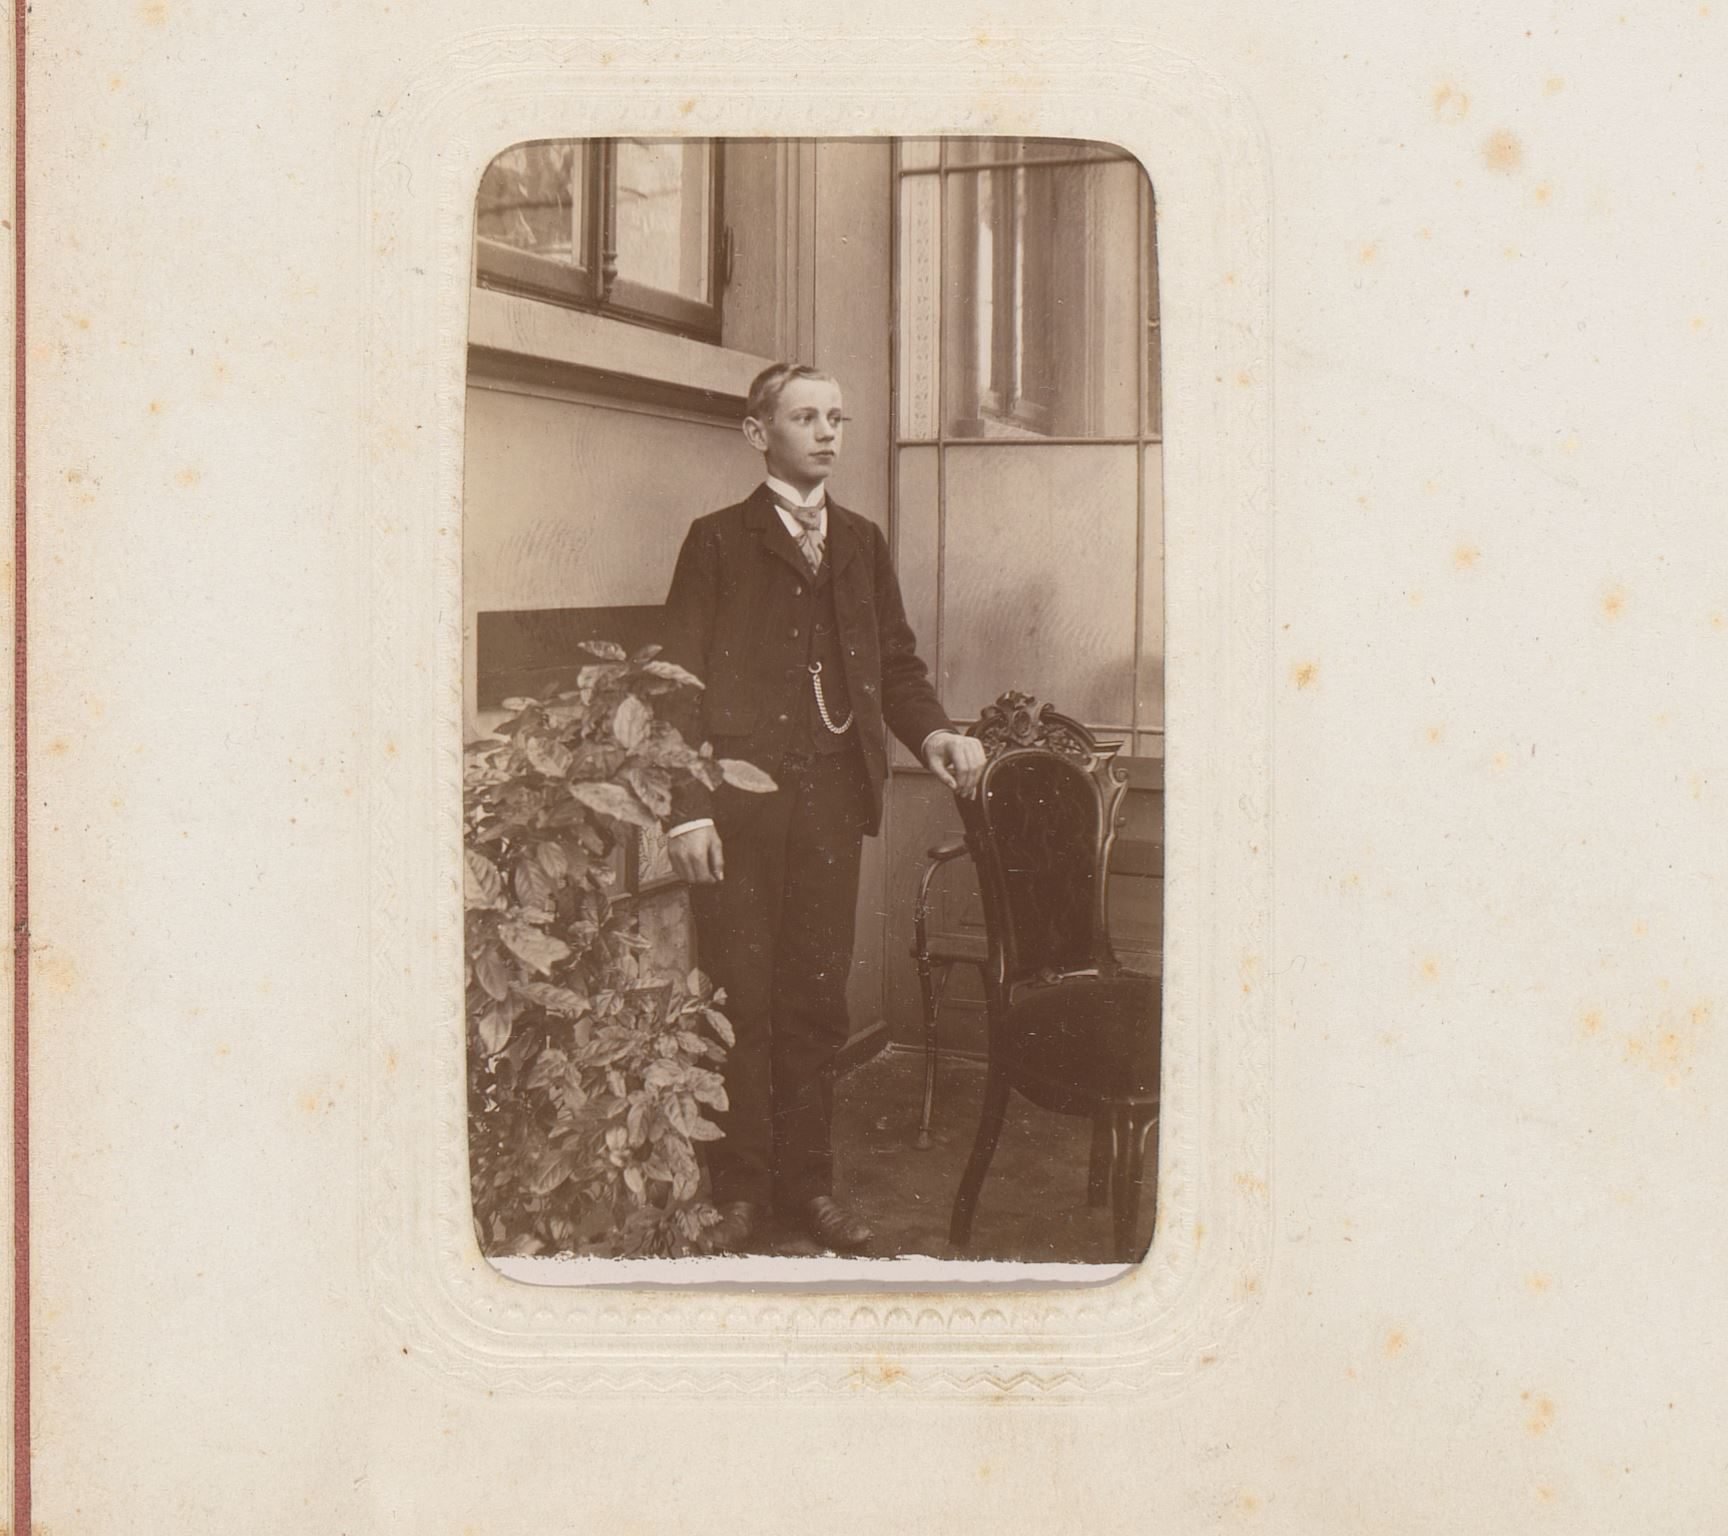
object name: carte de visite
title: Portret van een jongen, staand bij een stoel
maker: Anonymous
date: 1893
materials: cardboard, photographic support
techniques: collodion silver print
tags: boy (child between toddler and youth), historical persons, chair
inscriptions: date: ‘22. 10. 93.’